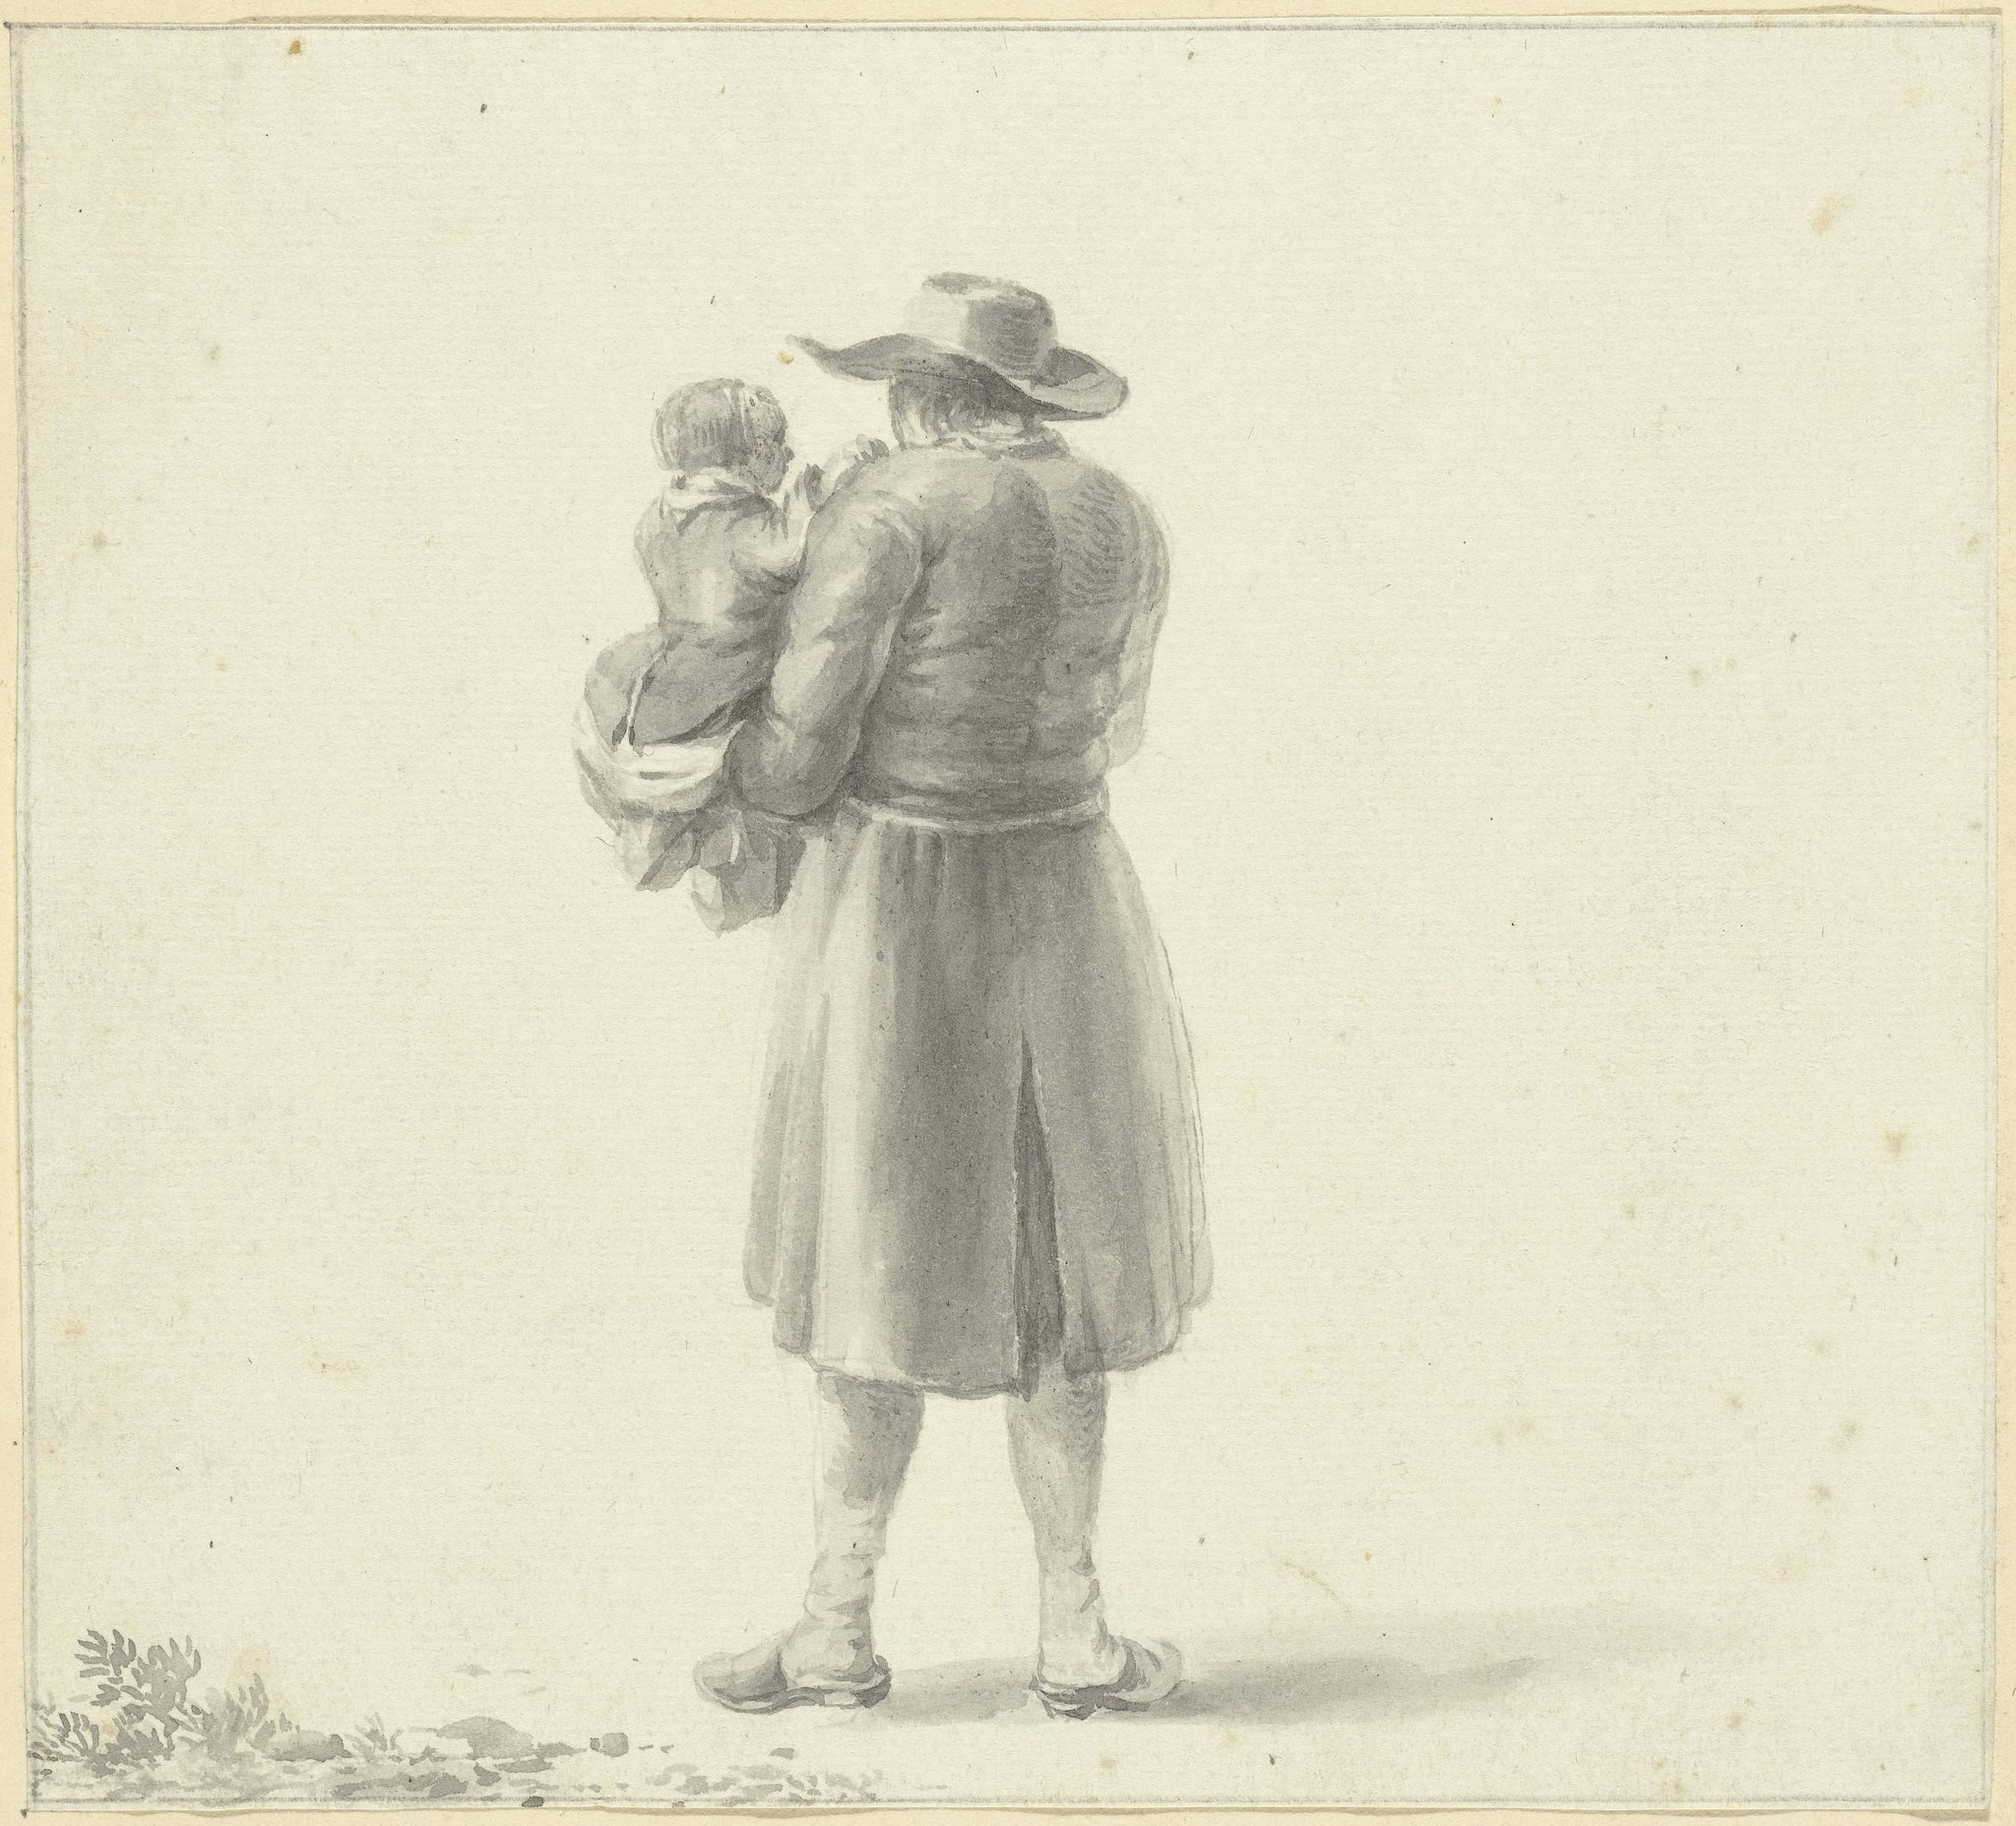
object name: drawing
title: Staande man met kind op de arm, op de rug gezien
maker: hendrik rietschoof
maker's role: draughtsman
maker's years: 1678-1746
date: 1697-1746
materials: ink, paper, pencil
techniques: brush, pen